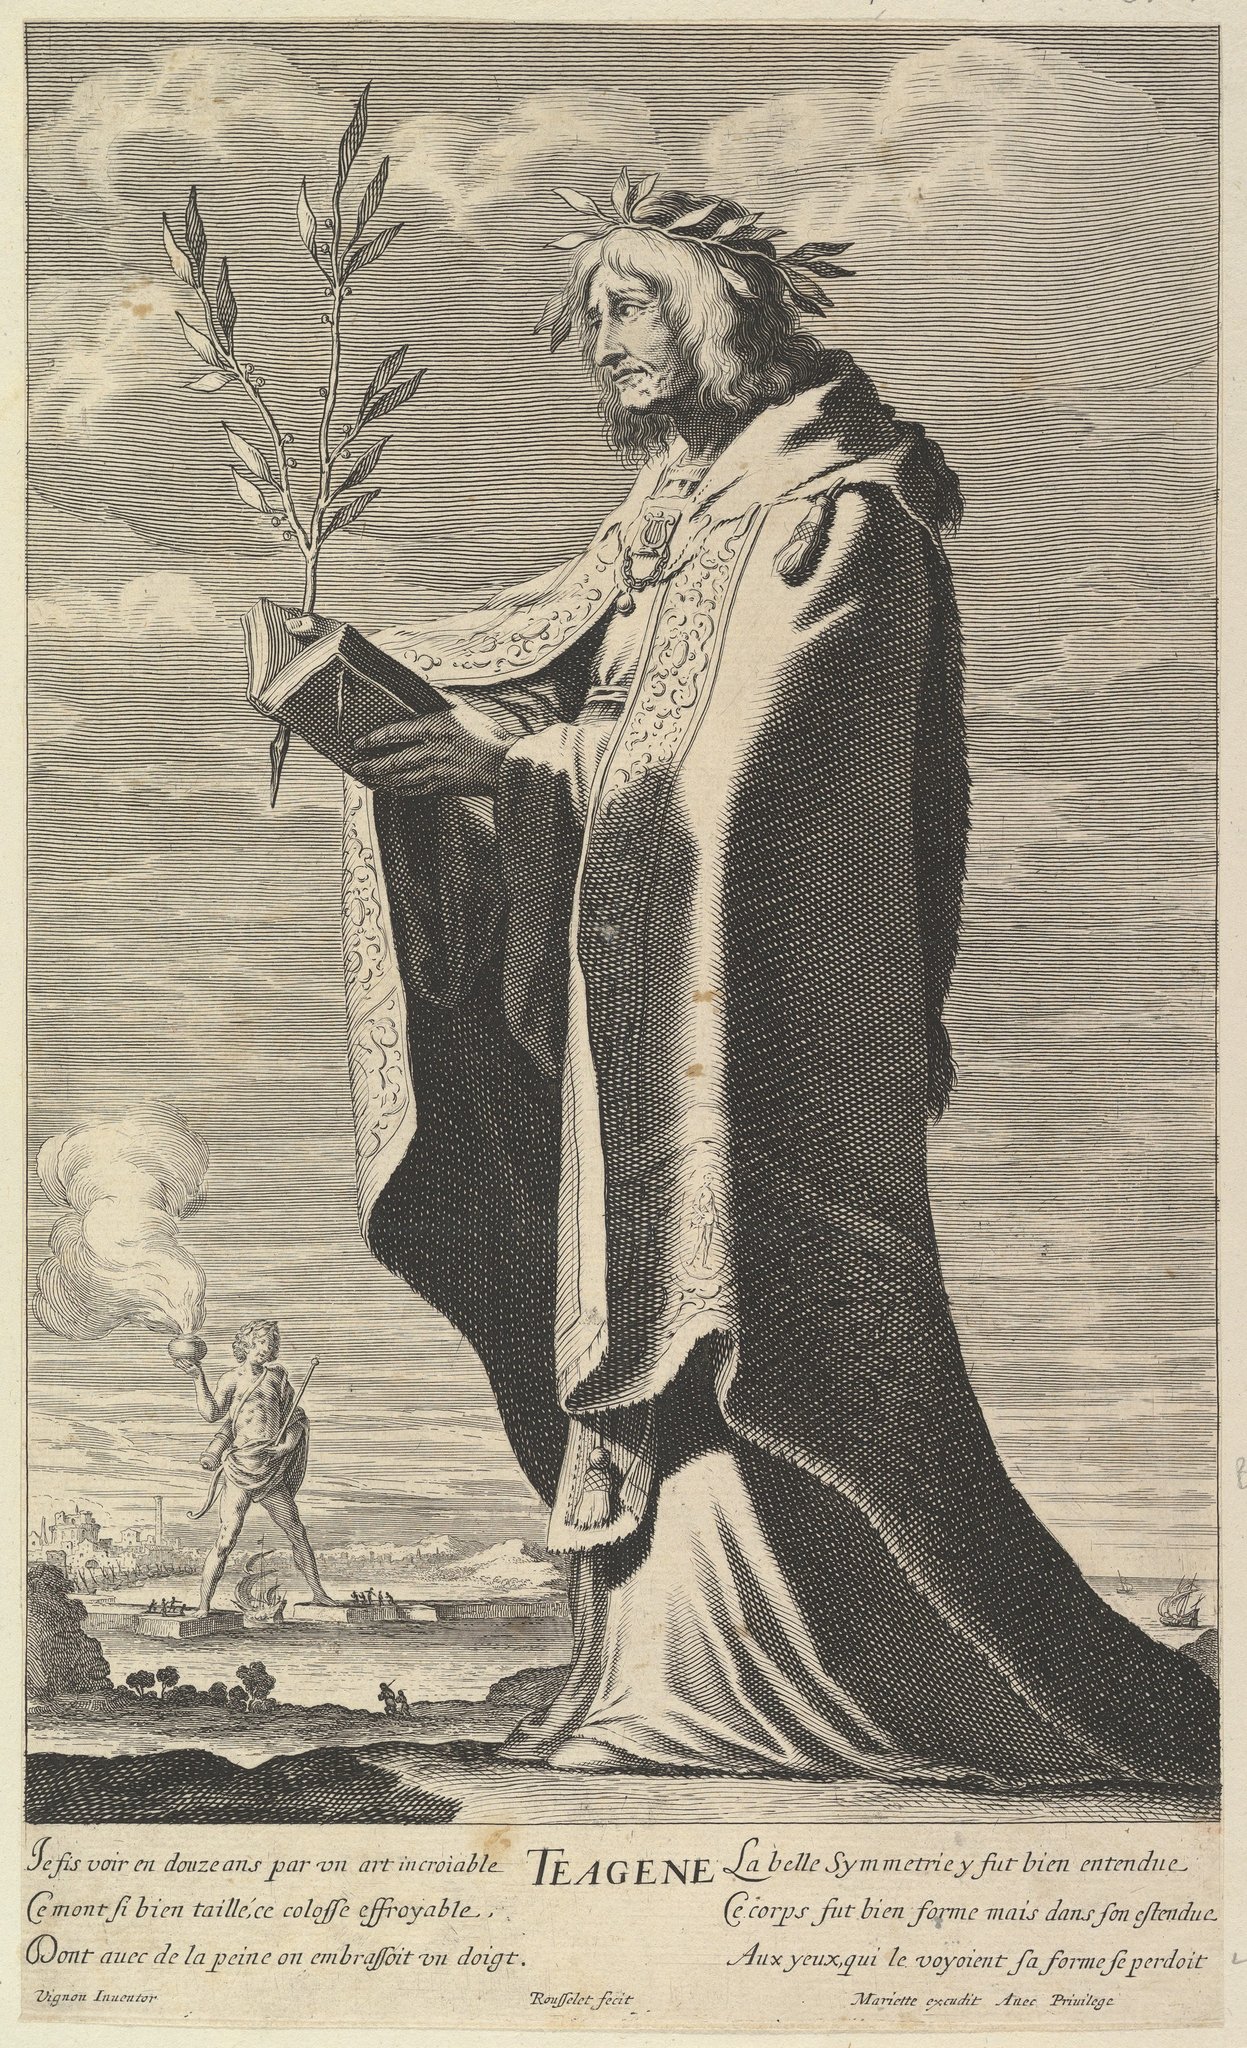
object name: print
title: Théagène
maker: gilles rousselet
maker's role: artist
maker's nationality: french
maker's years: 1614-1686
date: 1639-1640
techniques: engraving, etching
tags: books,men,leaves